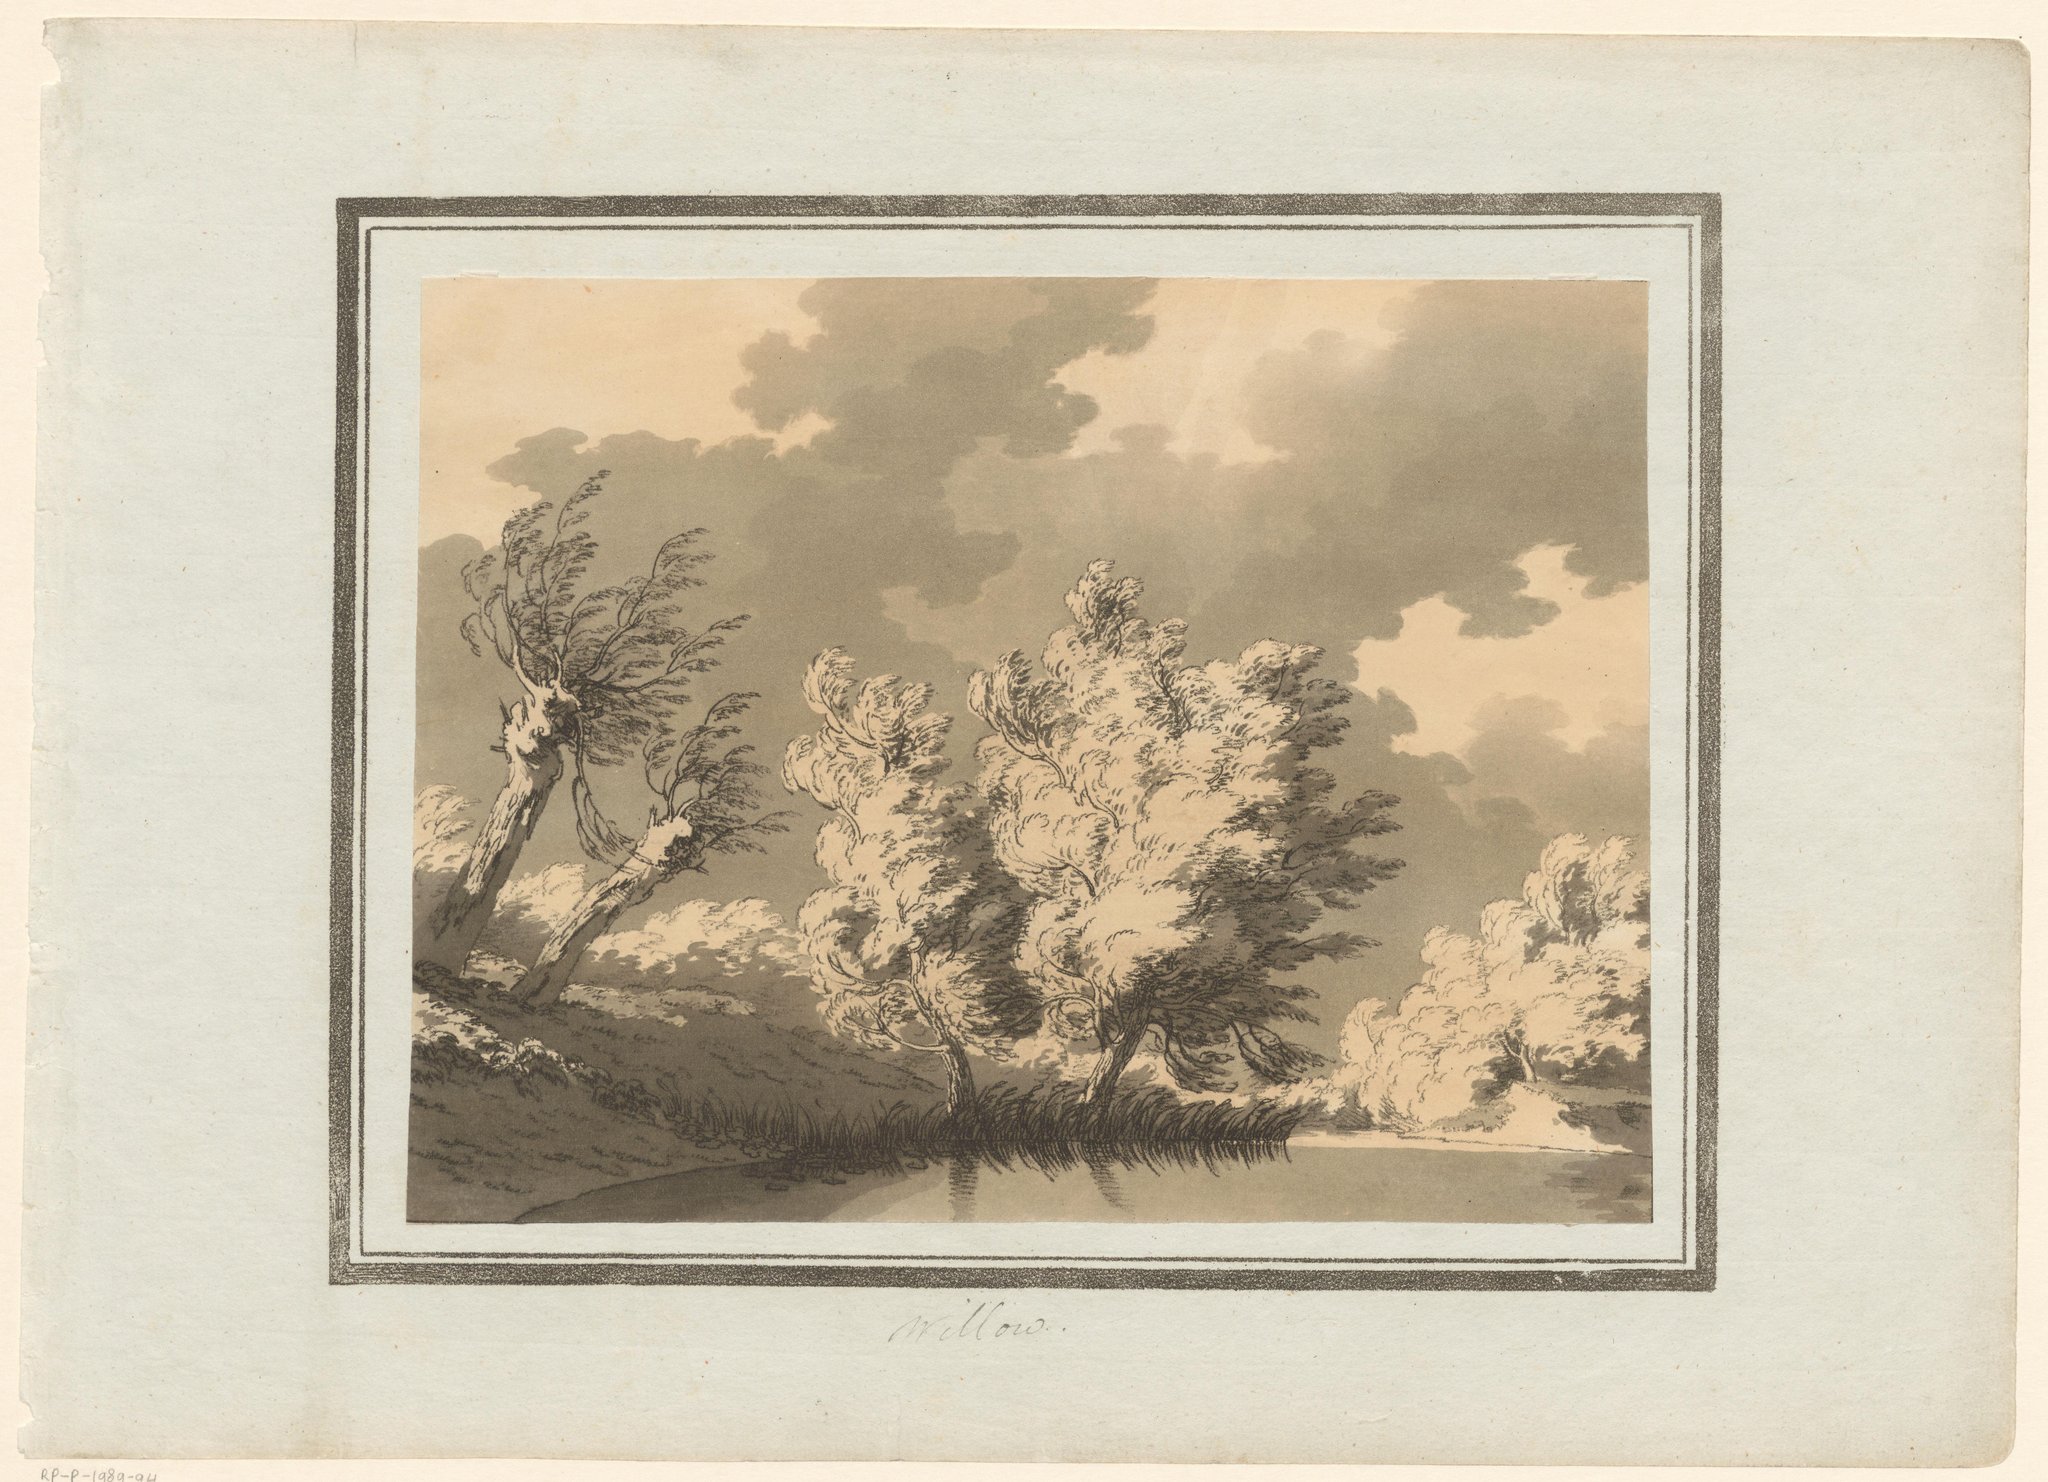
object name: print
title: Willow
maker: john robert cozens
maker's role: draughtsman, print maker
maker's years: 1752-1797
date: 1789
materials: ink, paper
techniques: aquatint, brush, soft ground etching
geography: london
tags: lake, trees: willow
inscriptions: collector's mark: Lugt 2760, collector's mark: Lugt 2228, title: ‘Willow.’